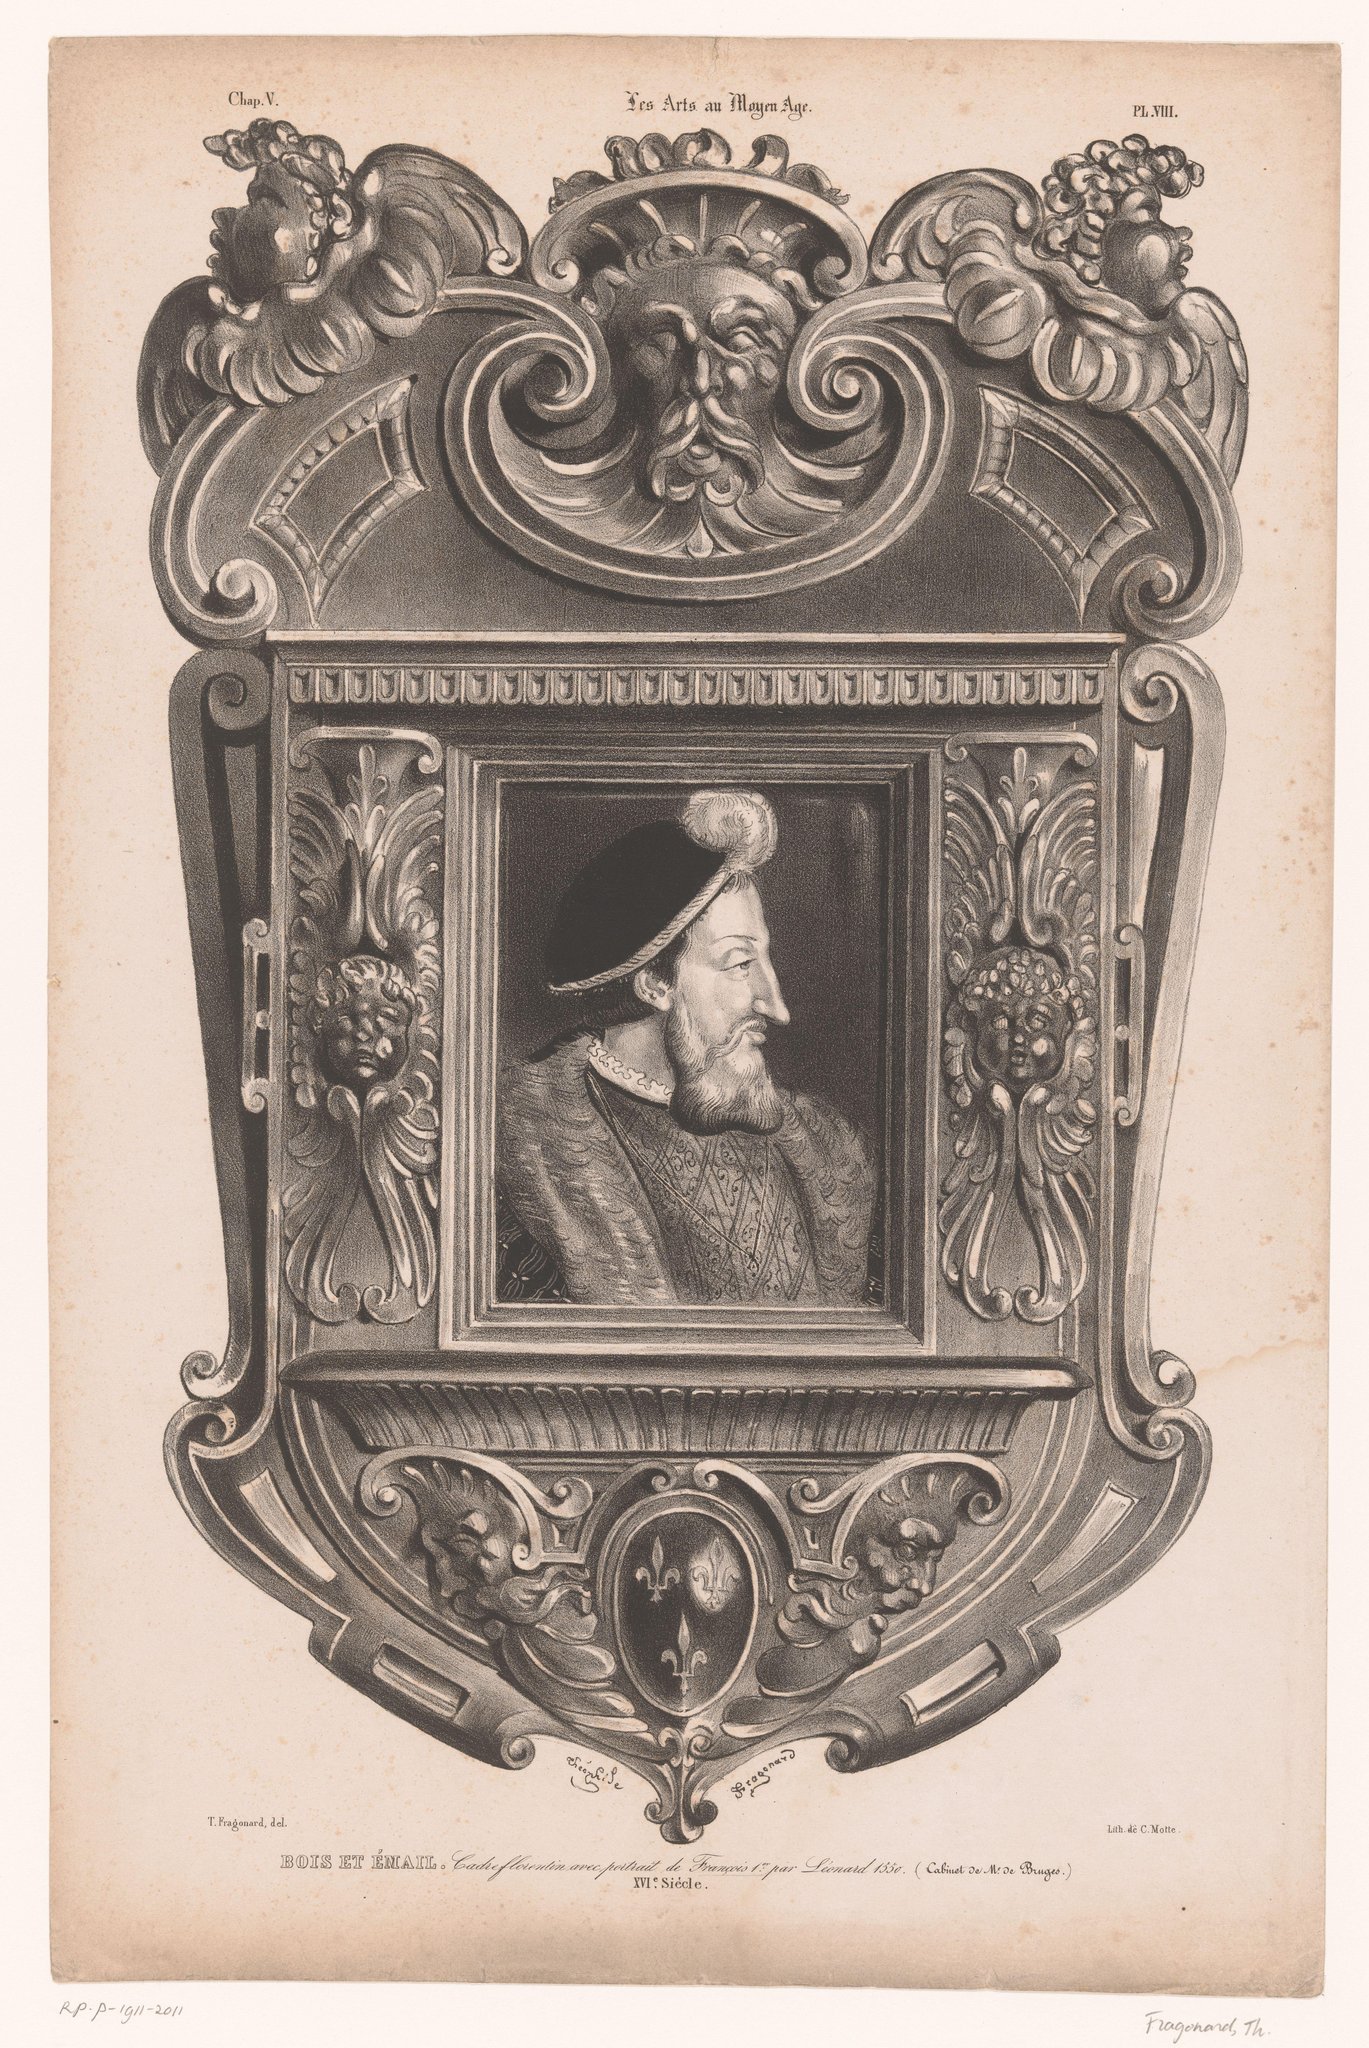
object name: print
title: Middeleeuwse kunst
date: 1838-1846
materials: paper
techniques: lithograph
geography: paris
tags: frans i van valois-angoulême (koning van frankrijk), floral interlace ~ ornament, historical persons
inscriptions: collector's mark: Lugt 2228a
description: Prent uitgegeven bij: Sommerard, Alexandre du. Les arts au Moyen Age. En ce qui concerne principalement le Palais Romain de Paris, l'Hotel de Cluun (…). 5 dln. Parijs: s.n., 1838-1846. De volledige uitgave van 'Les arts au Moyen Age' bestond uit de vijf hierboven genoemde boeken met tekst en daarbij horende prenten die los van de tekst zijn uitgegeven. De prenten zijn verdeeld onder 'L'Atlas' en 'L'Album'. 'L'Album' is onderverdeeld in tien delen met ieder 40 prenten. Het serienummer verwijst dus naar het nummer van deze prent binnen de 40 prenten van dat deel. In sommige gevallen is het serienummer aangepast en komt het nummer op de prent niet overeen met het nummer in het hieronder vermelde overzicht. Voor de precieze inhoud van het tekstgedeelte, 'L'Atlas' en 'L'Album', zie: Sommerard, Alexandre du. Les arts au Moyen Age. En ce qui concerne principalement le Palais Romain de Paris, l’Hotel de Cluun (…). 5 dln. Parijs: s.n., 1838-1846, dl. 5 (1846) p. 379-429.